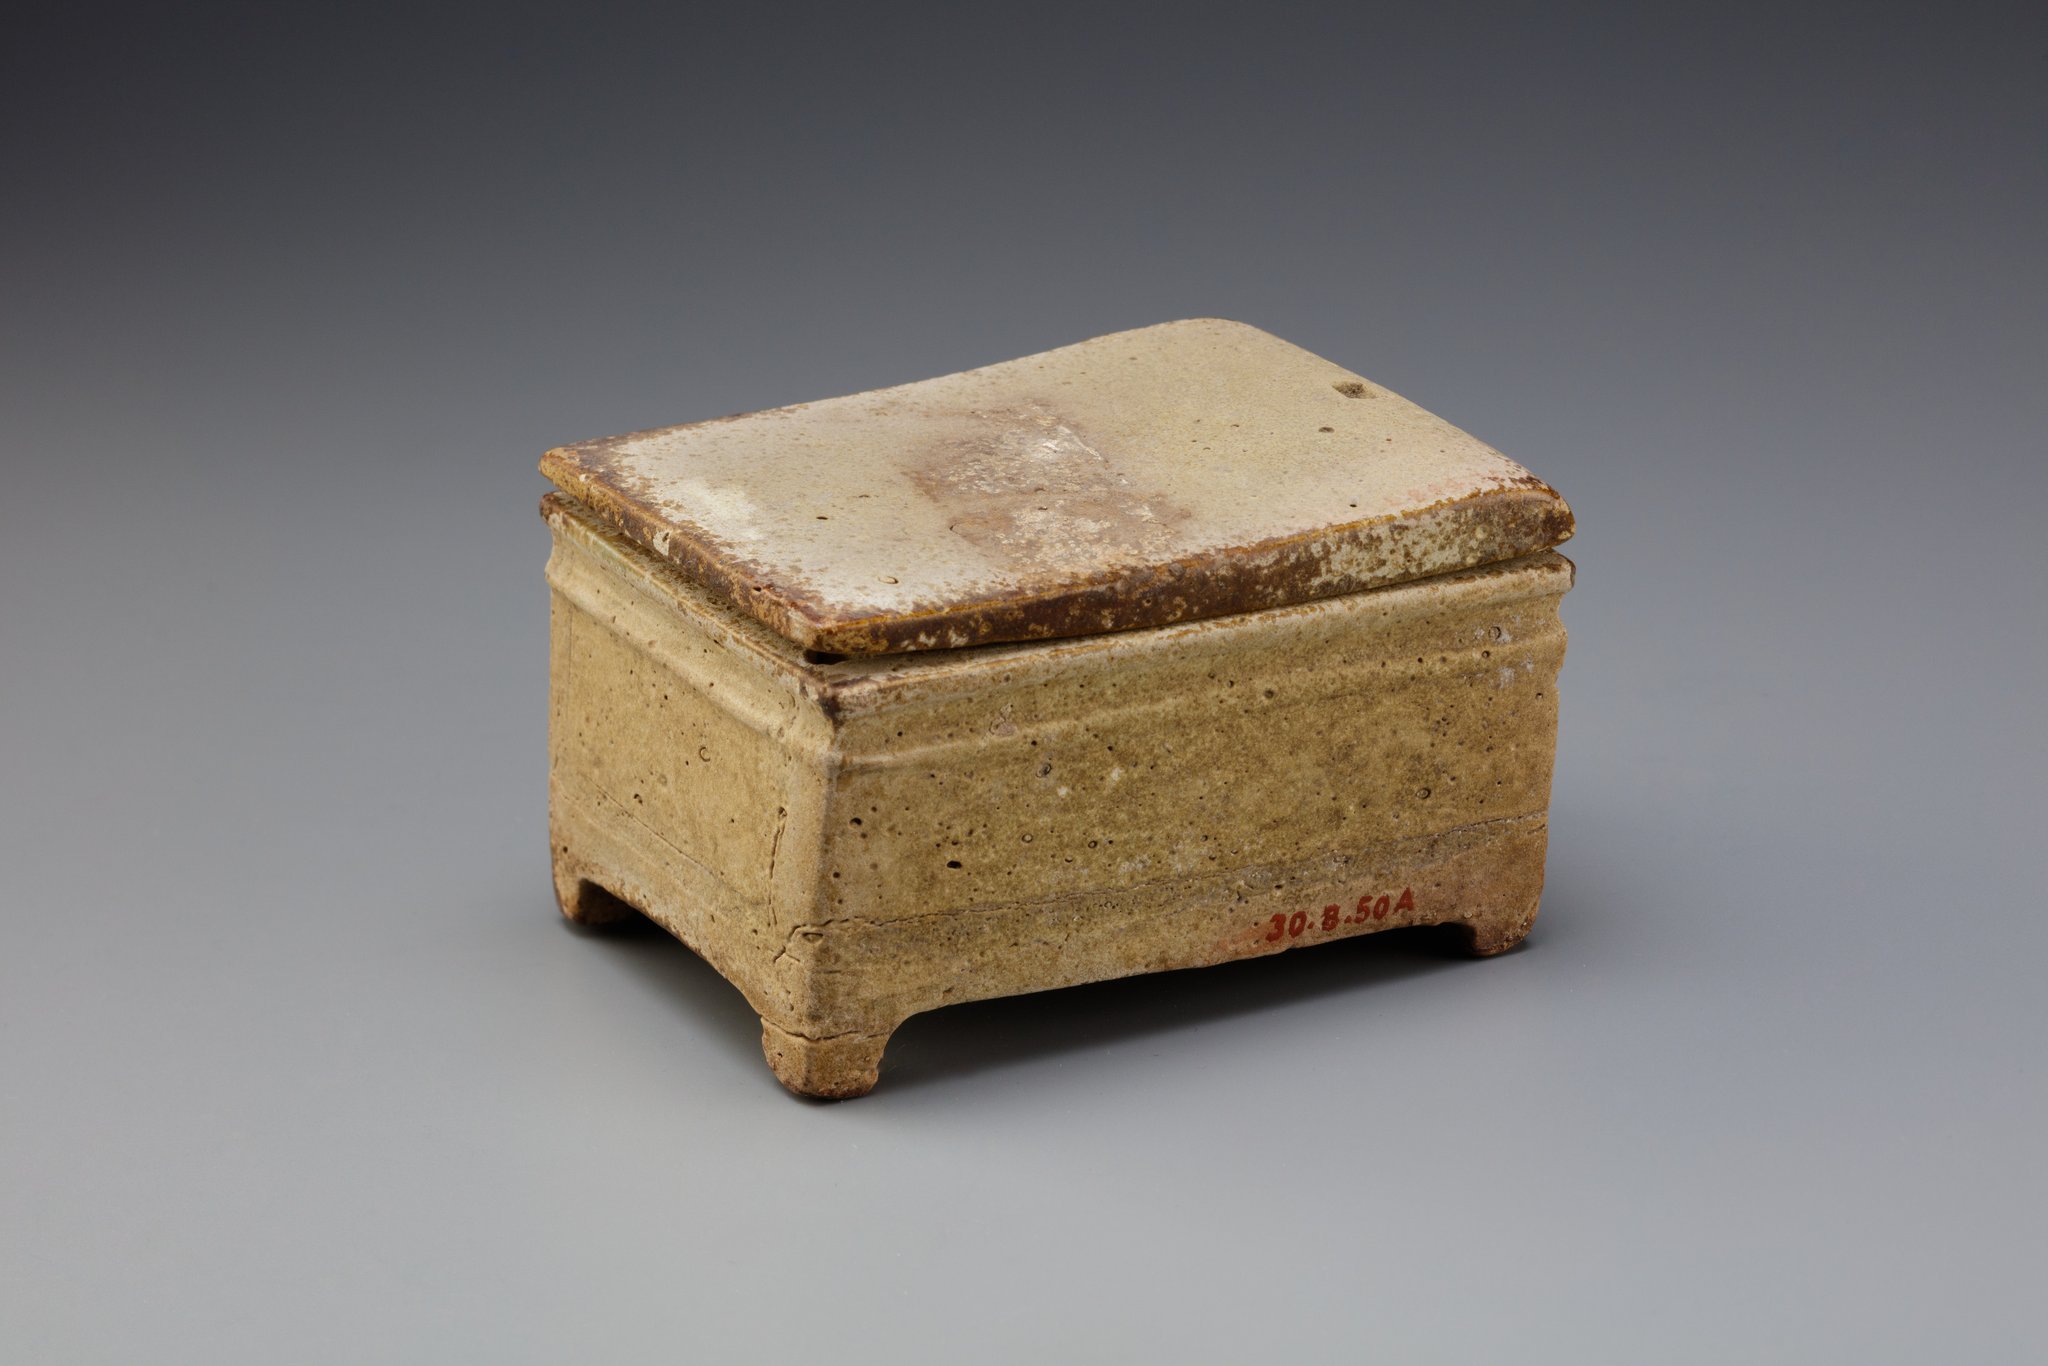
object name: model box, with lid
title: Model Box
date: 1353-1295 BCE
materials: faience